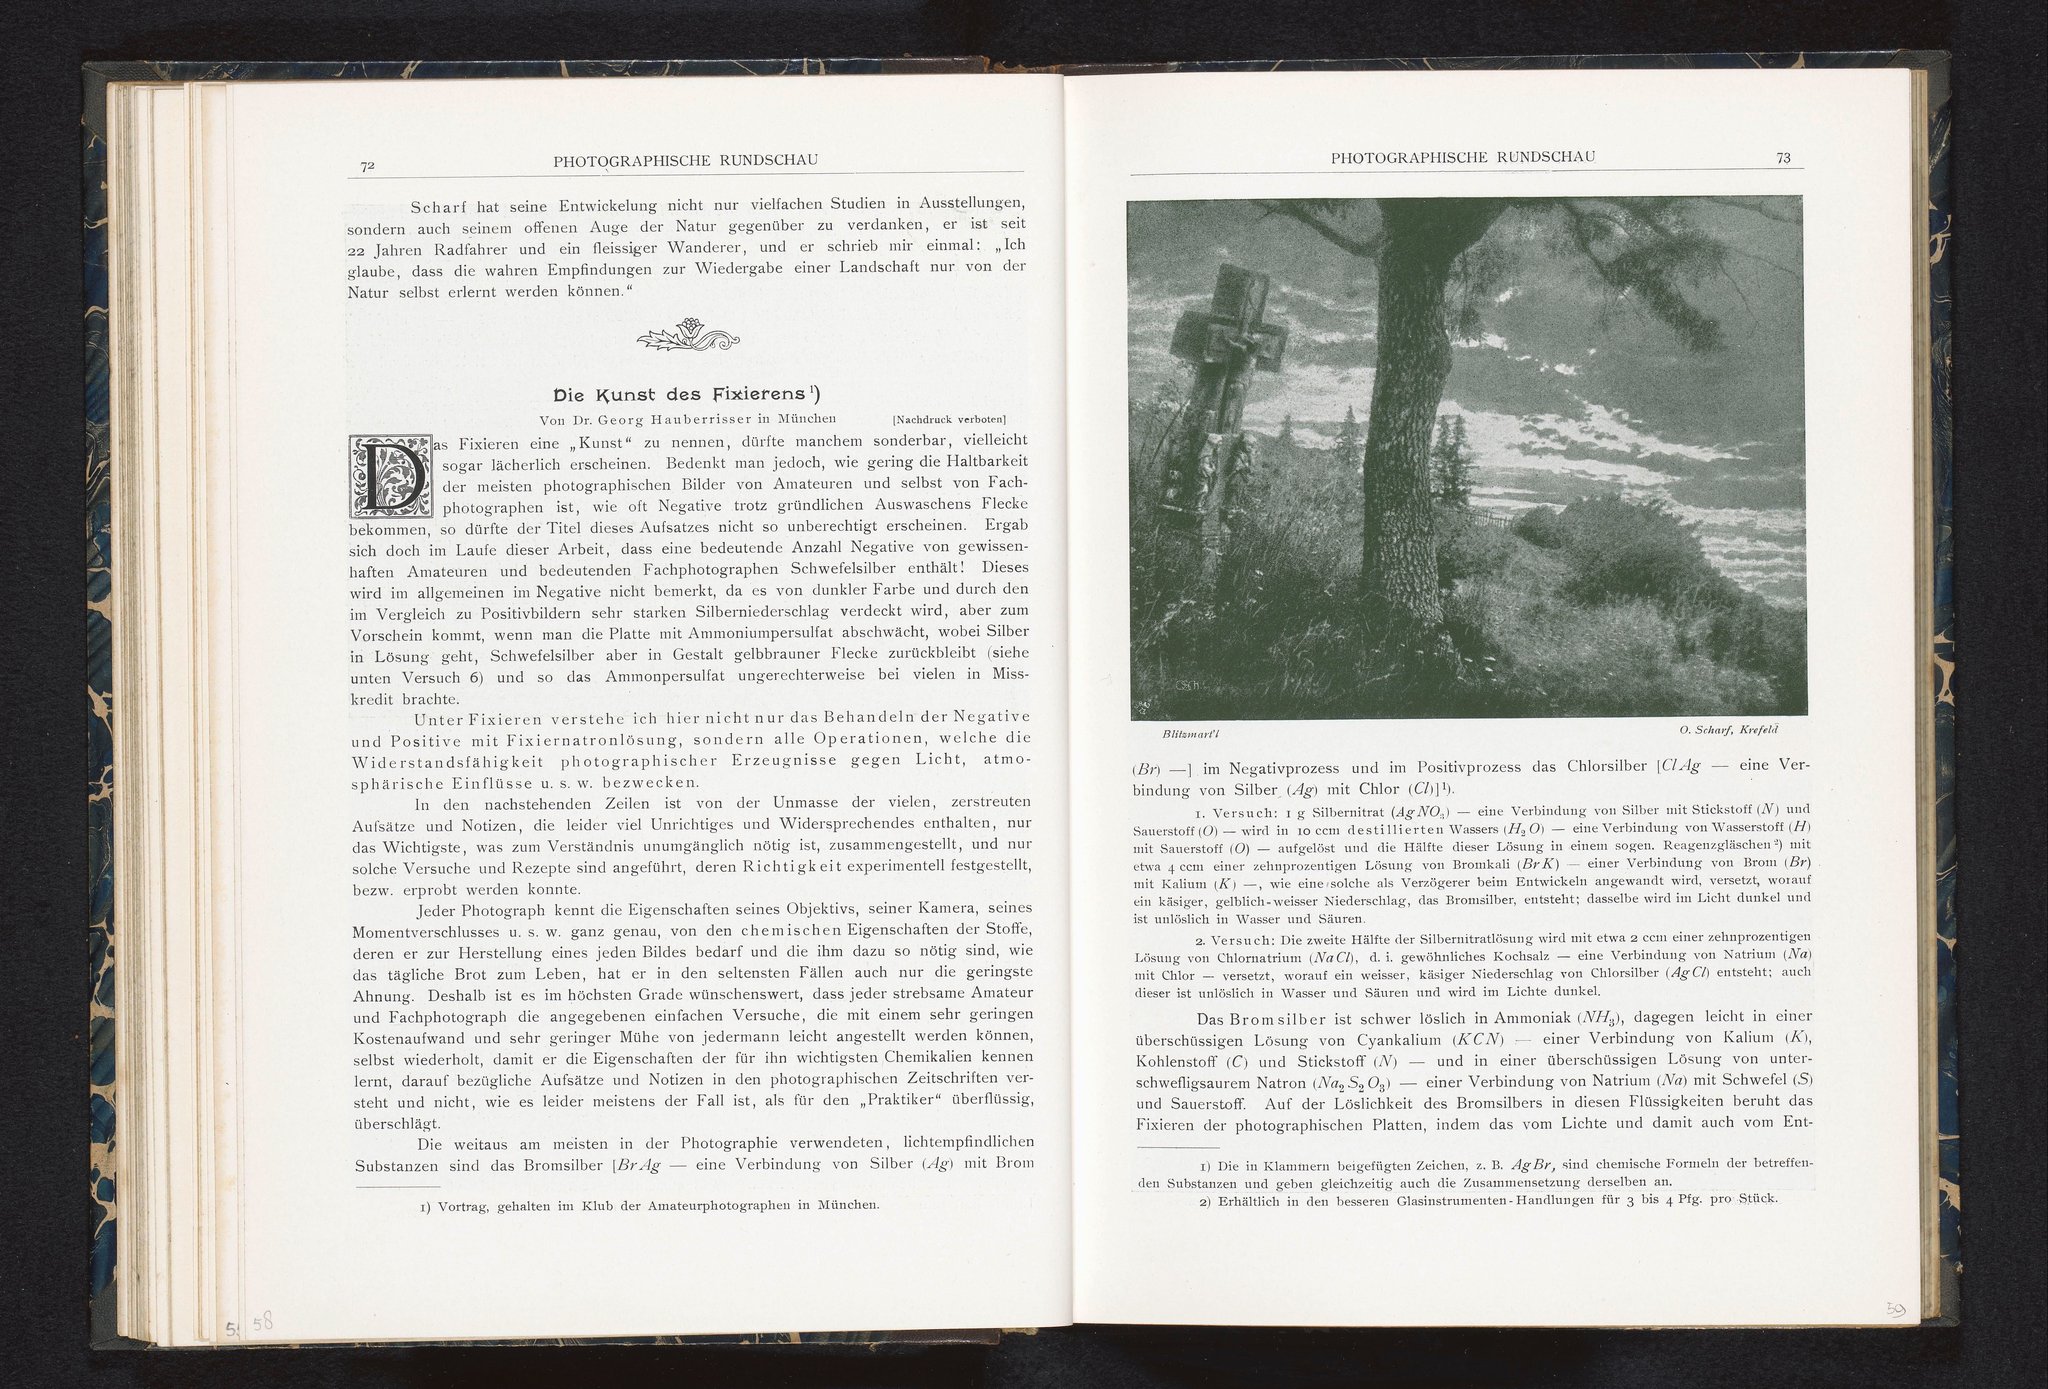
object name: photomechanical print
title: Landschap, met links een sculptuur van Christus aan het kruis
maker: otto scharf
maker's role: fotograaf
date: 1900-1901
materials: paper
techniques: autotype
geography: berlin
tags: landscapes, cross ~ instruments of the passion